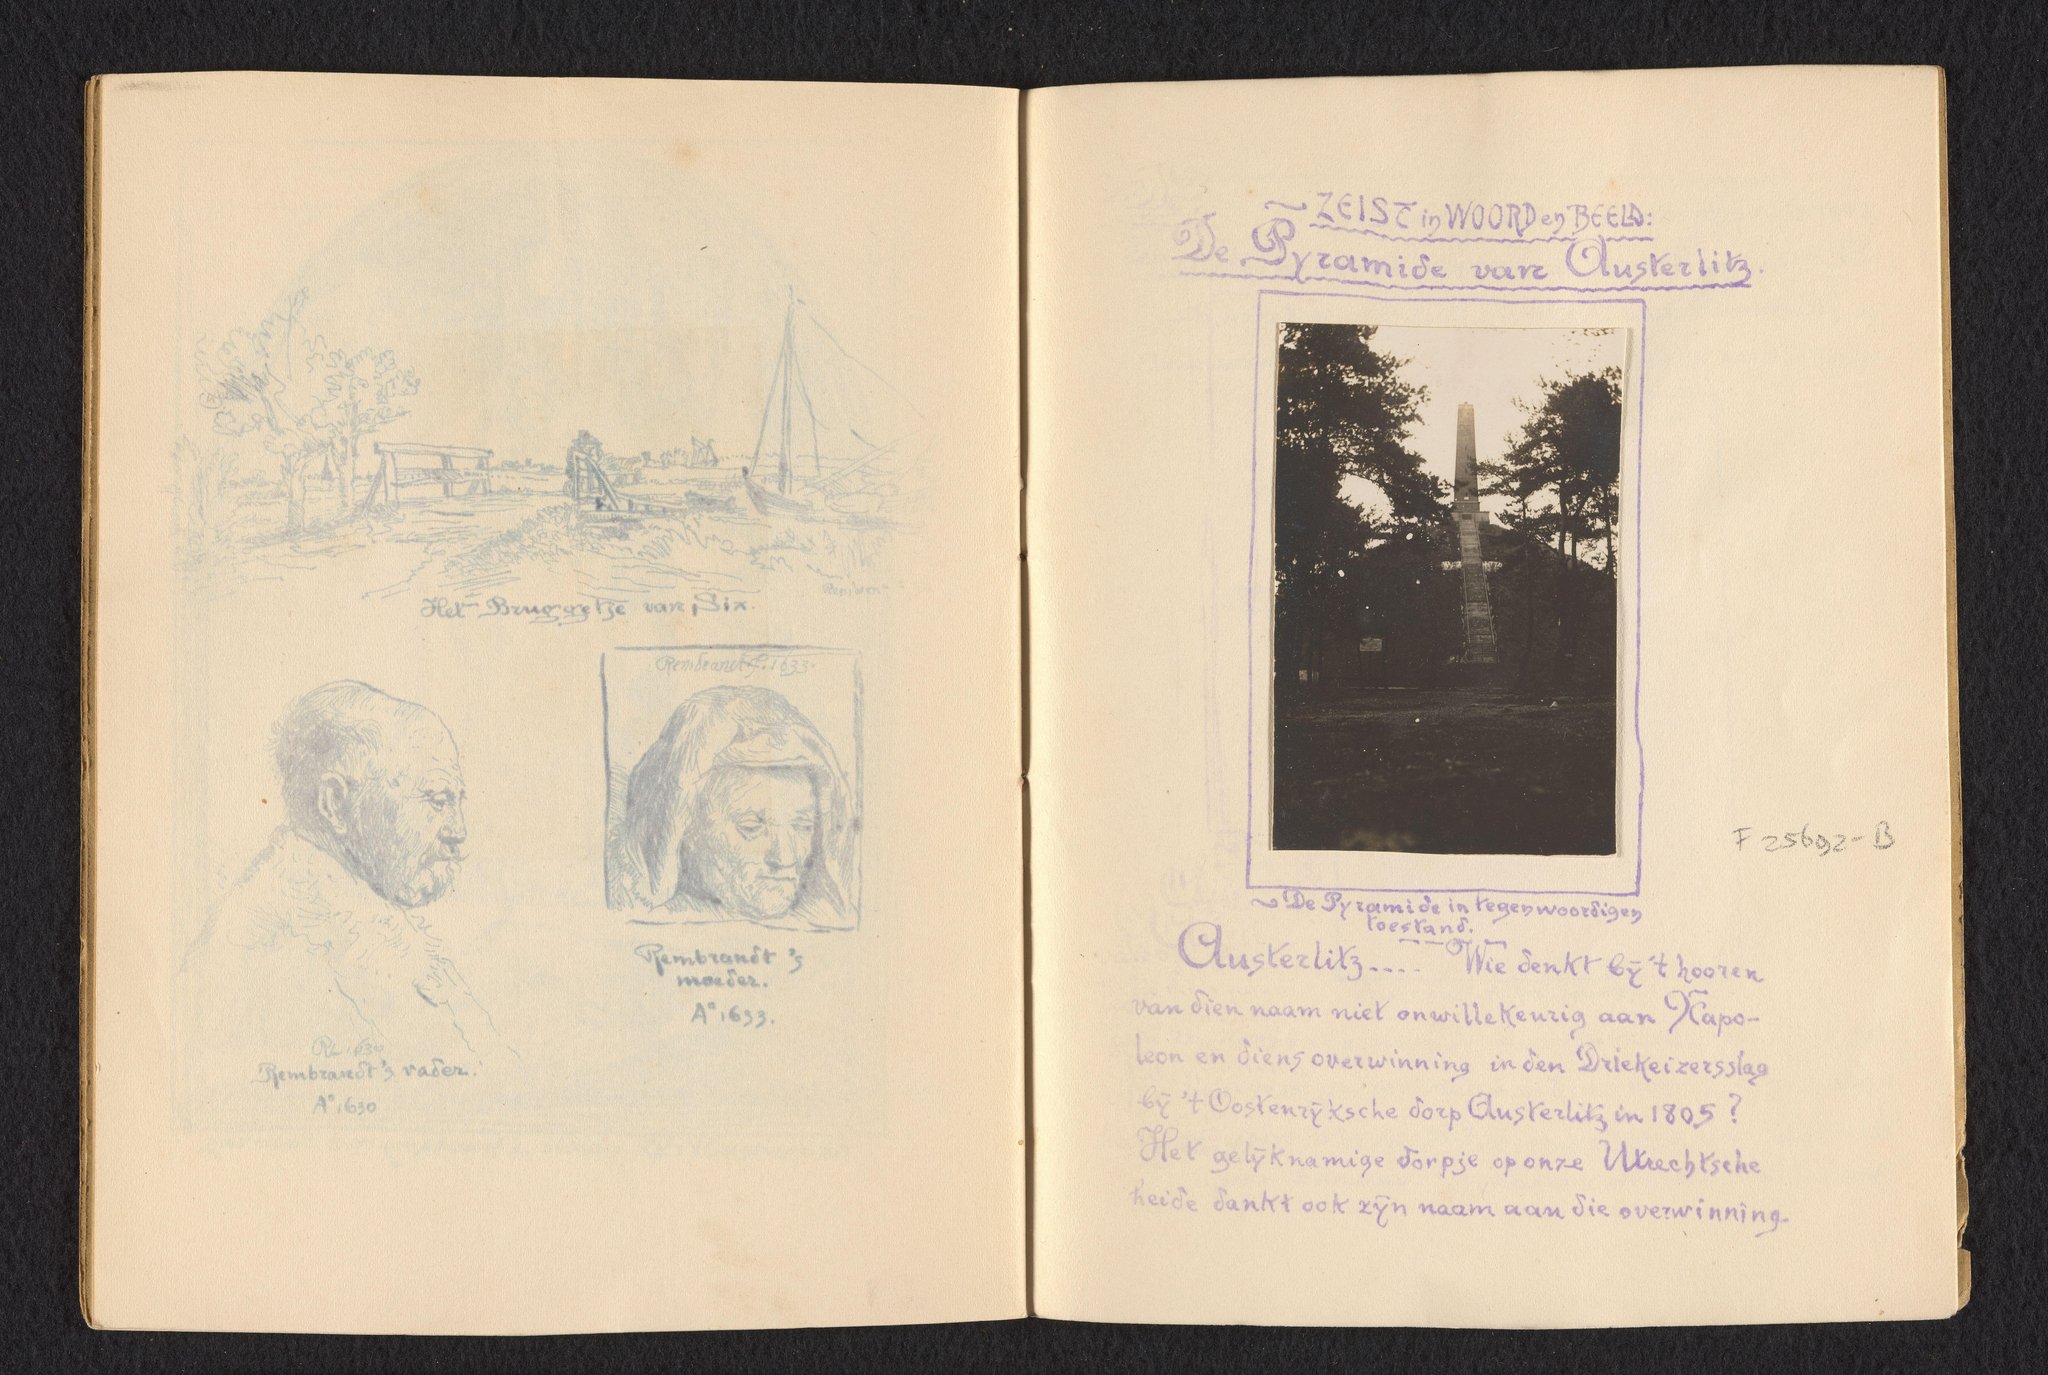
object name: photograph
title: Pyramide van Austerlitz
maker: Anonymous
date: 1912-1917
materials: paper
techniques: gelatin silver print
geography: woudenberg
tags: obelisk, needle, landscape with monument